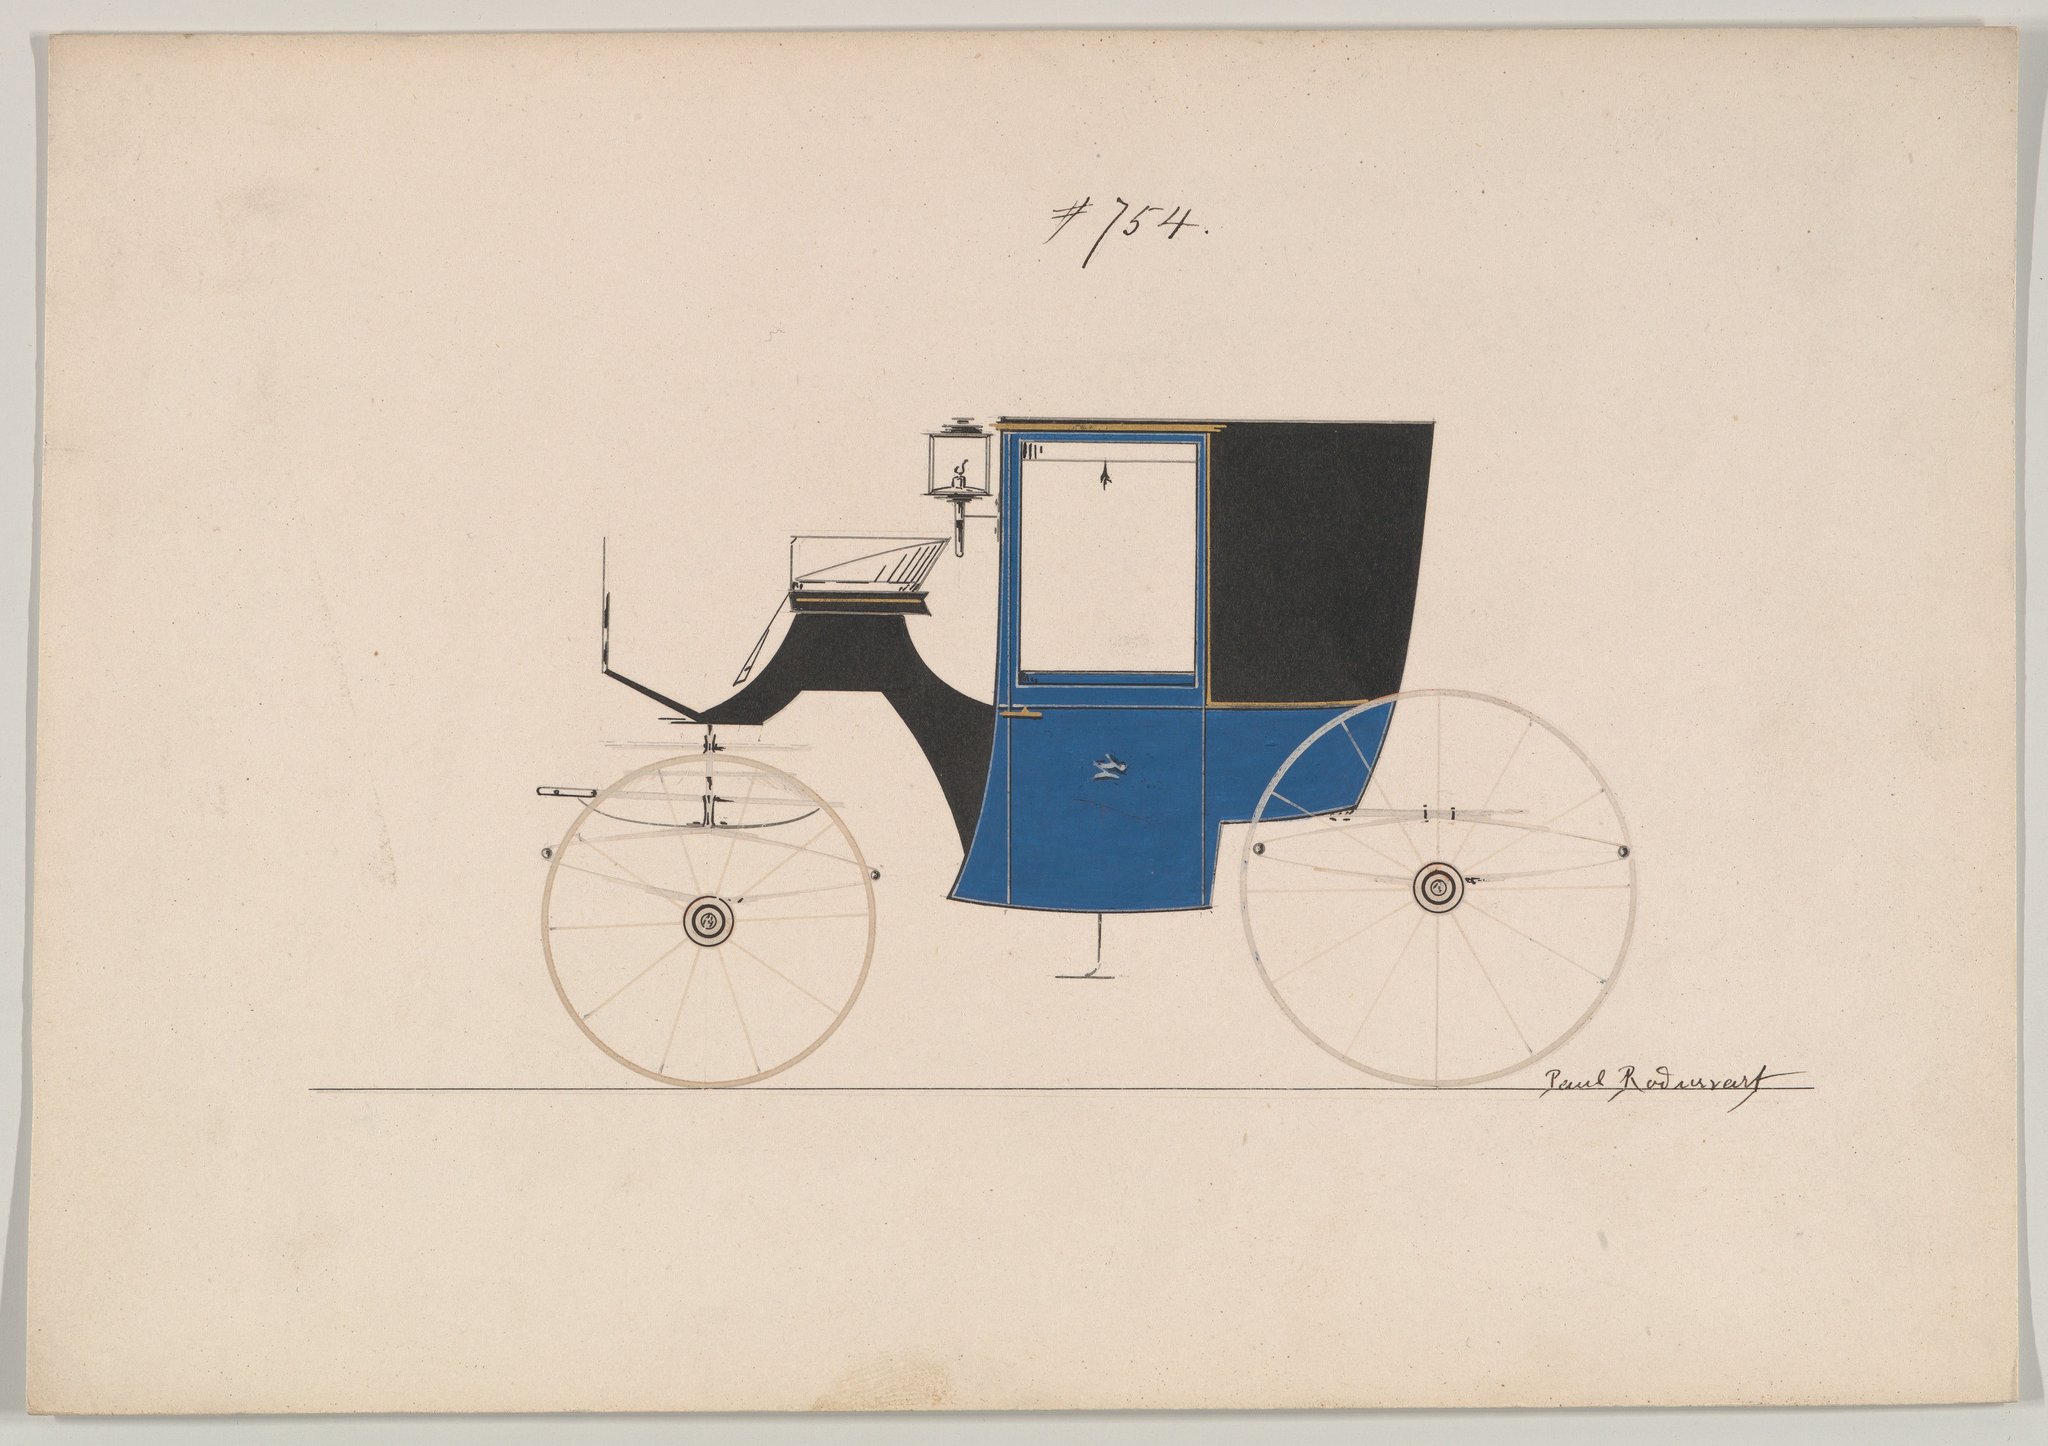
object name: drawing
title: Coupe #754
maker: brewster & co.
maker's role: manufacturer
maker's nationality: american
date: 1860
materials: gouache, ink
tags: carriages